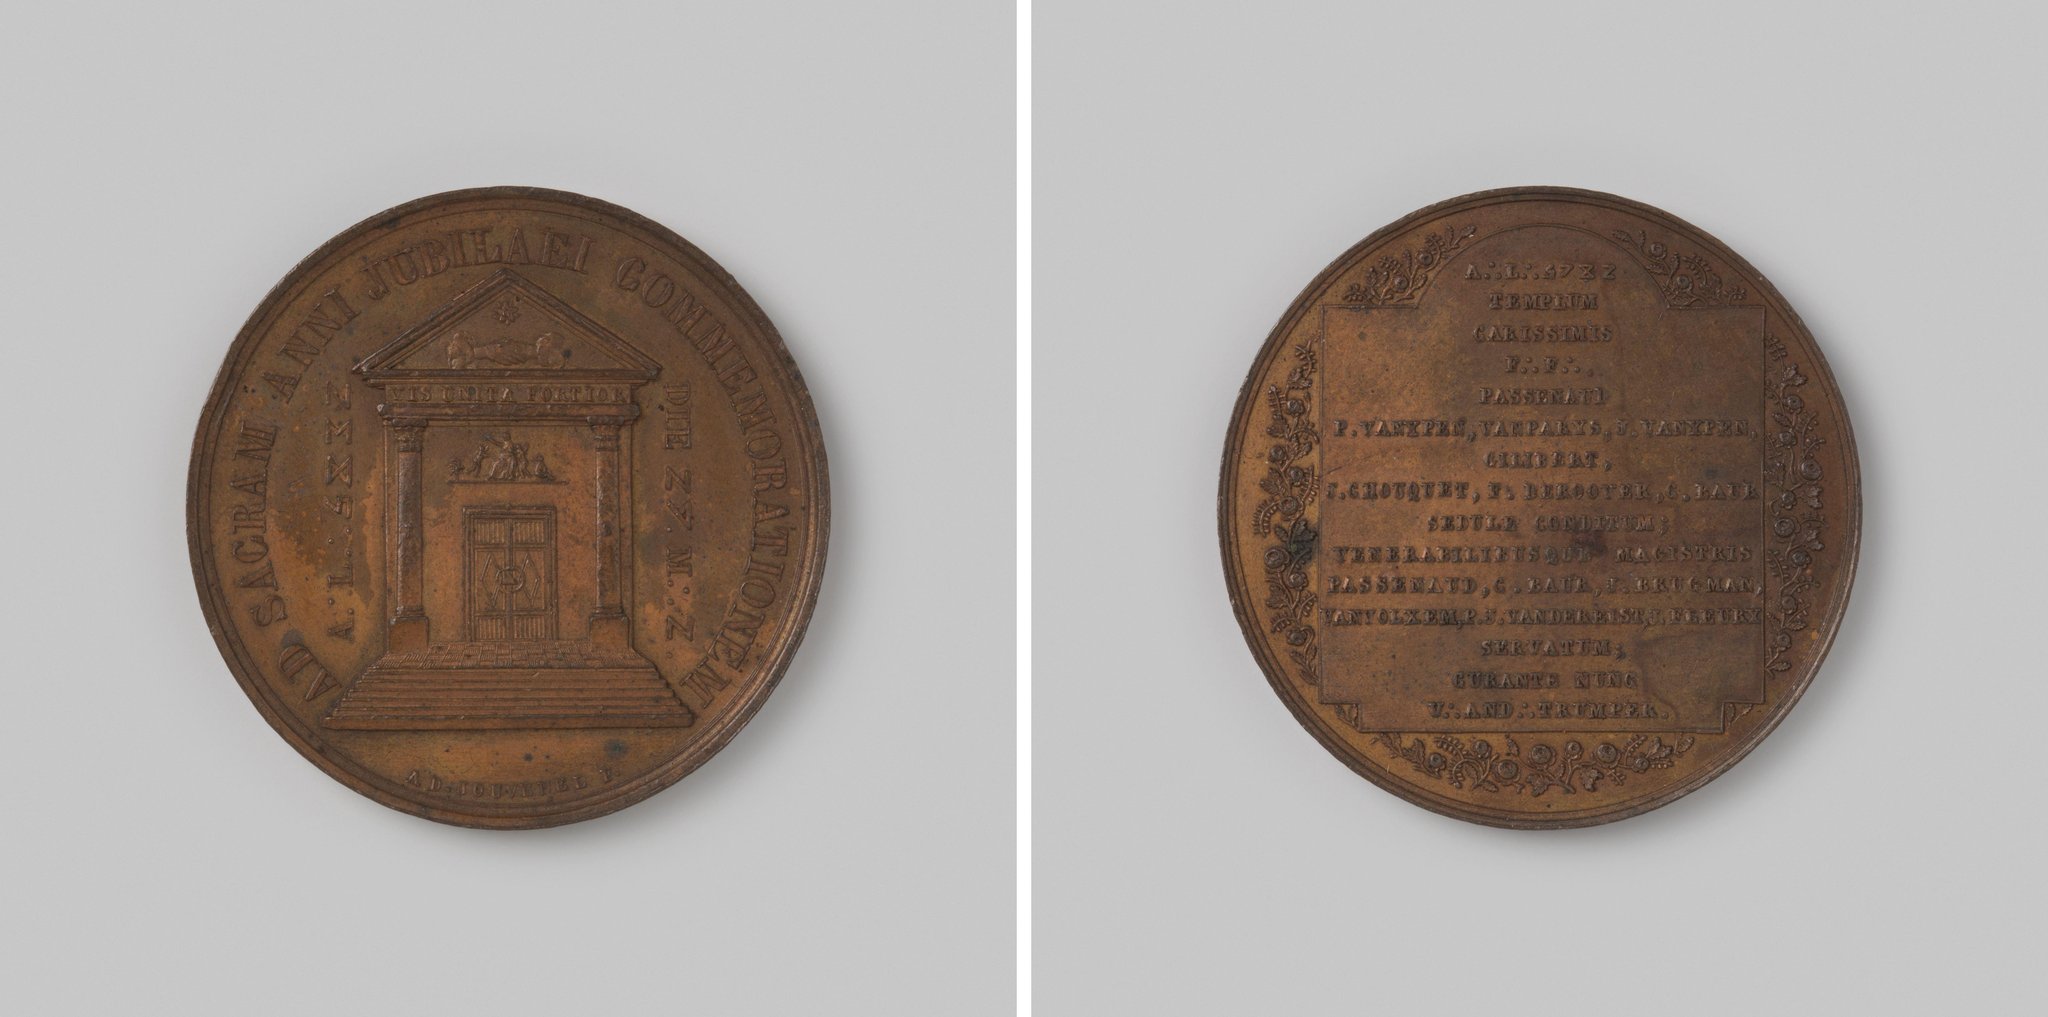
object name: history medal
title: Vijftigjarig bestaan van de vrijmetselaarsloge "Les Vrais Amis de l'Union"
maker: adolphe jouvenel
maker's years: 1798-1867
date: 1832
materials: bronze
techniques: striking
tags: brussels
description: Bronzen penning. Voorzijde: tempel met zeven treden; in gevelveld twee ineen geslagen handen ondervlammende ster met daarin letter G binnen omschrift. Keerzijde: tableau met opschrift binnenrozekrans